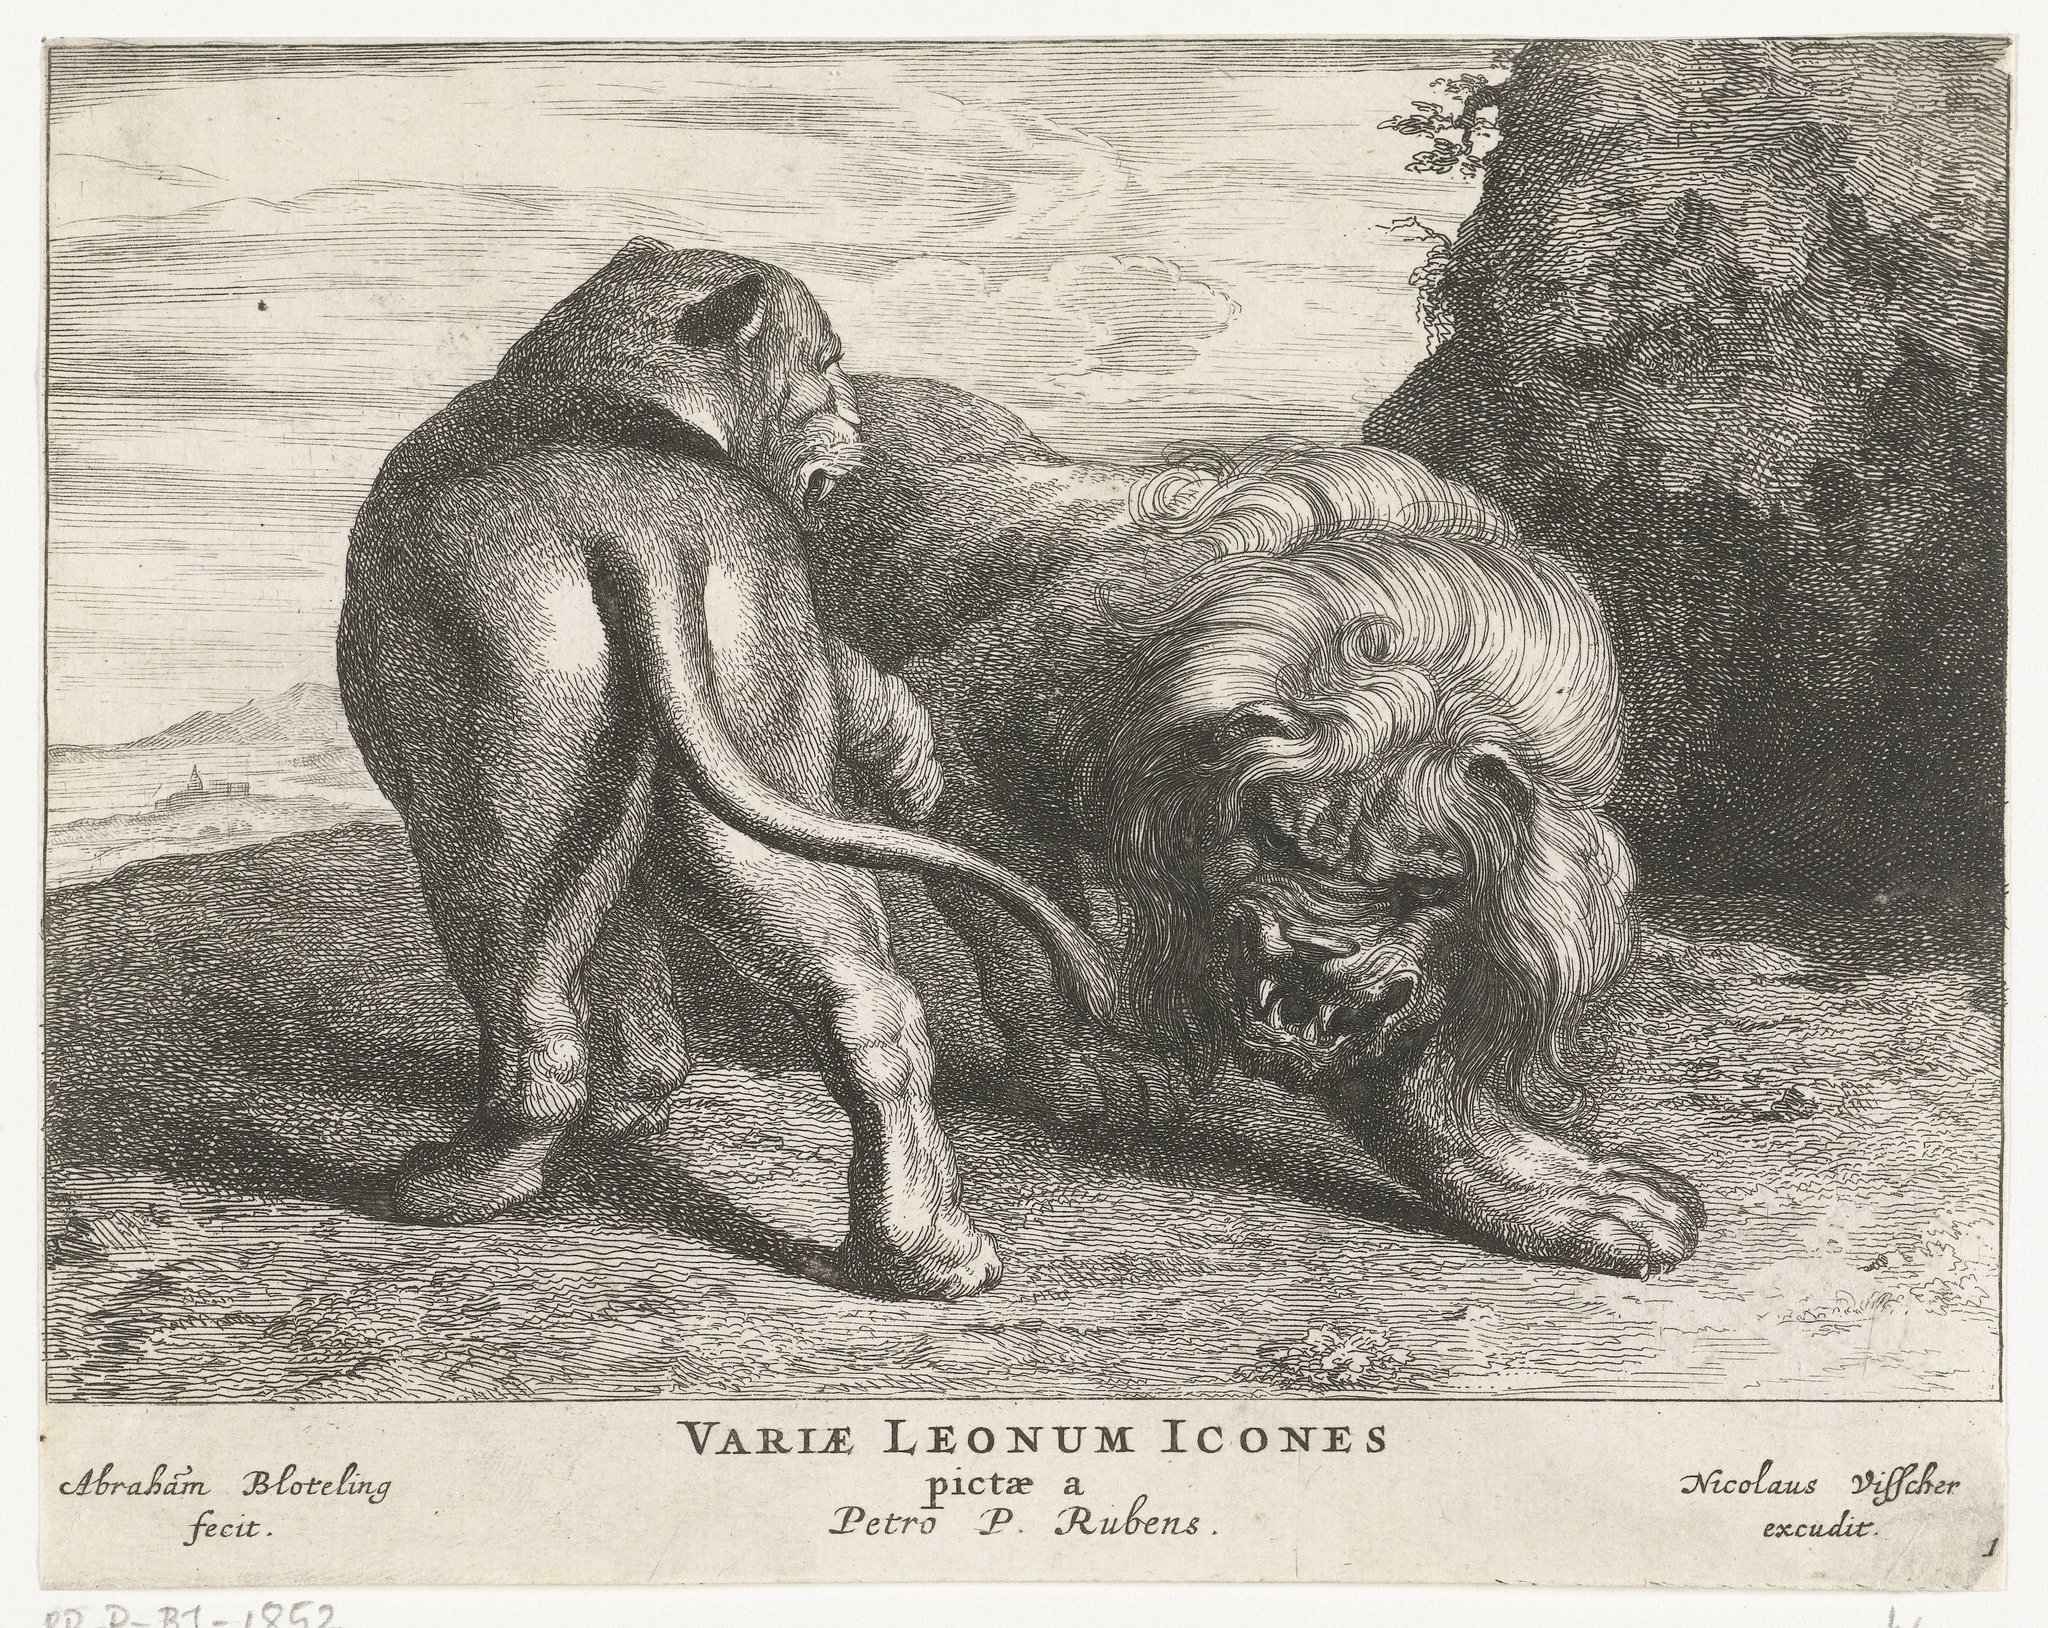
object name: print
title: Leeuw met leeuwin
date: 1655-1690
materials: paper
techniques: etching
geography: amsterdam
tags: beasts of prey, predatory animals: lion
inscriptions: collector's mark: Lugt 240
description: Een leeuw en een leeuwin draaien rondjes om elkaar heen. De leeuw laat zijn tanden zien. Prent uit een serie van vier prenten met voorstellingen van leeuwen naar Pieter Paul Rubens.